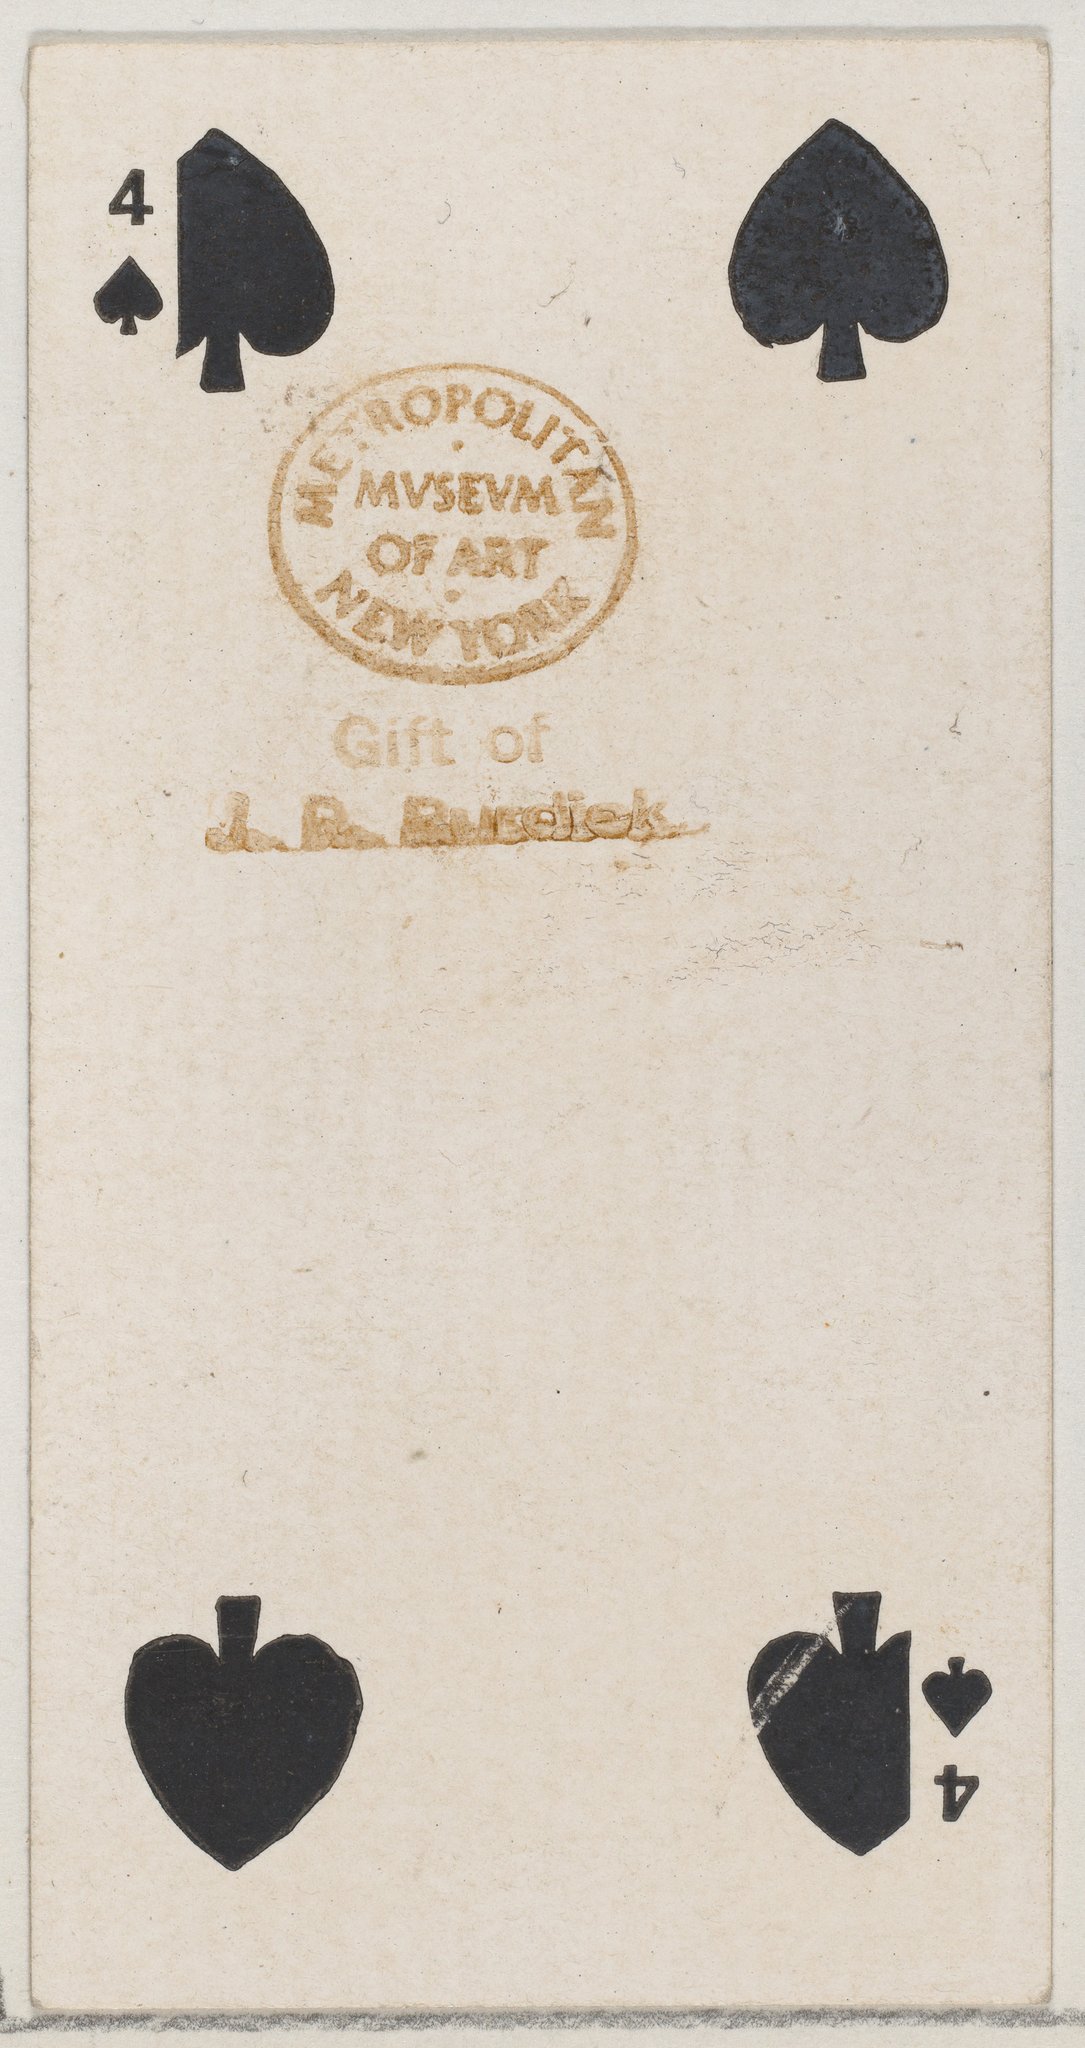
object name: print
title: Four Spades (black), from the Playing Cards series (N84) for Duke brand cigarettes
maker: w. duke, sons & co.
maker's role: publisher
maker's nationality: american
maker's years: 1870-1920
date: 1888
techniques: color lithograph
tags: playing cards